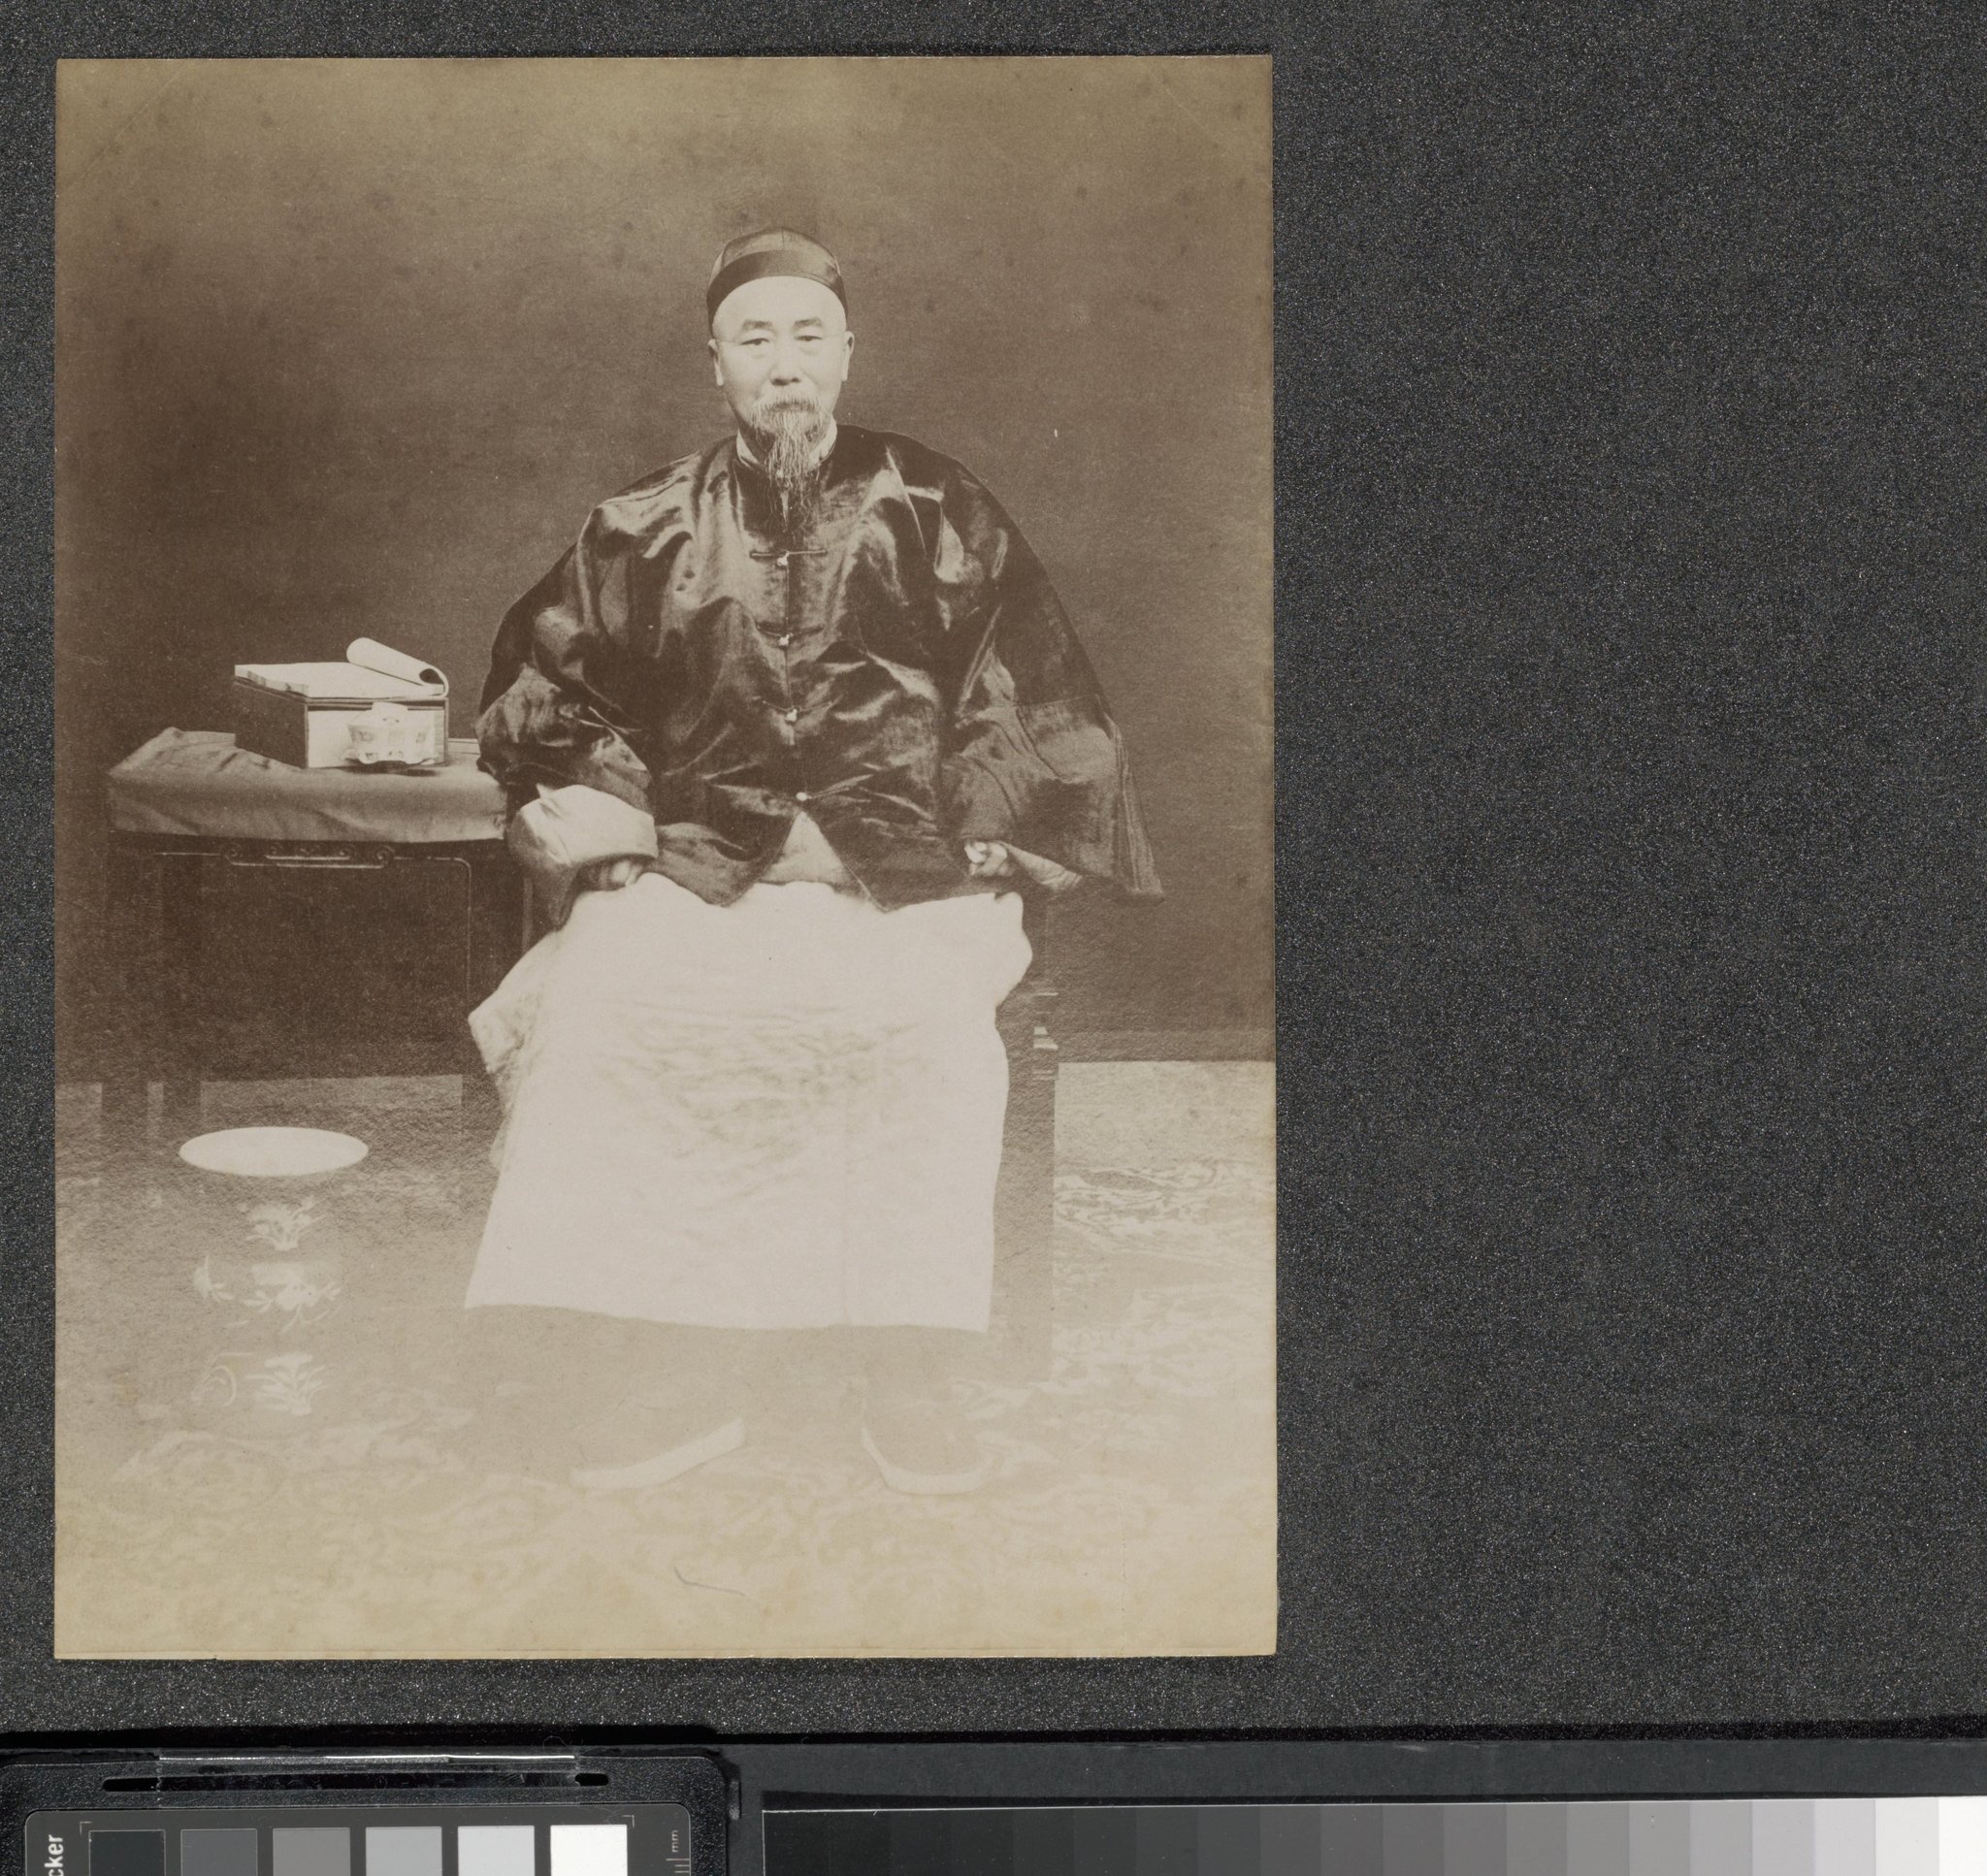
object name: photograph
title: Portret van Li Hongzhang, Chinees mandarijn en onderkoning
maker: Anonymous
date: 1860-1880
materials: paper, photographic support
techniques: albumen print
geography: china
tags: china, politician, politician, e.g. party leader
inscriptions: inscription: ‘Li Hung Chang Viceroy [...] Tienstsin vice koning’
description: Onderdeel van Album met 50 foto's van een reis door Zuidoost-Azië.